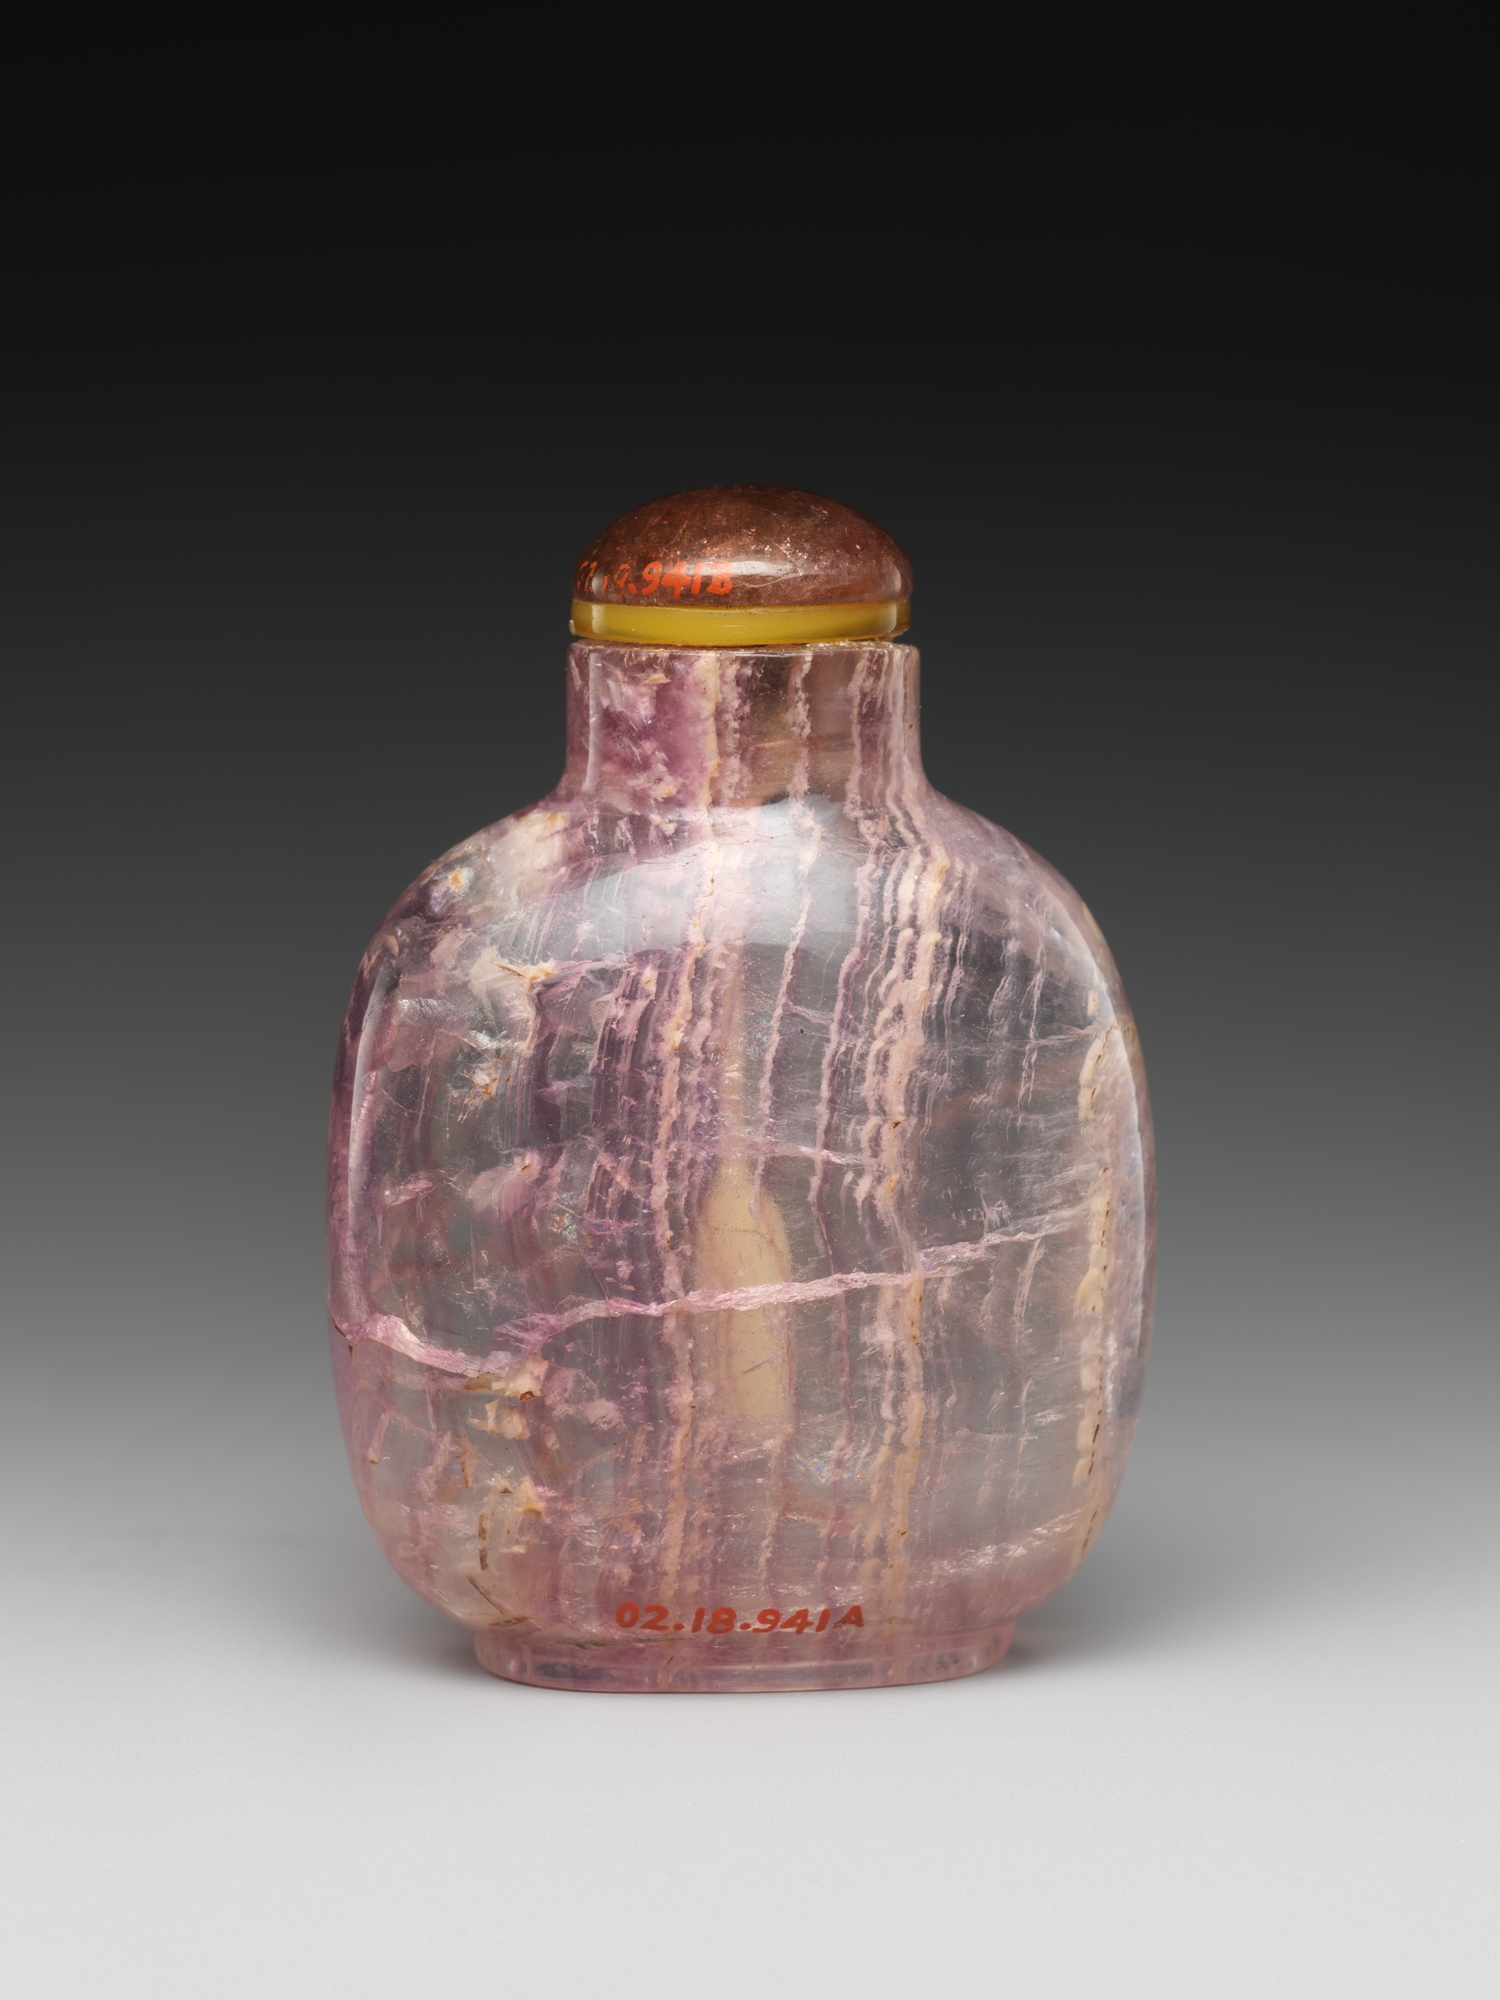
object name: snuff bottle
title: Snuff bottle with stopper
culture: chinese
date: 1767-1833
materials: gemstone